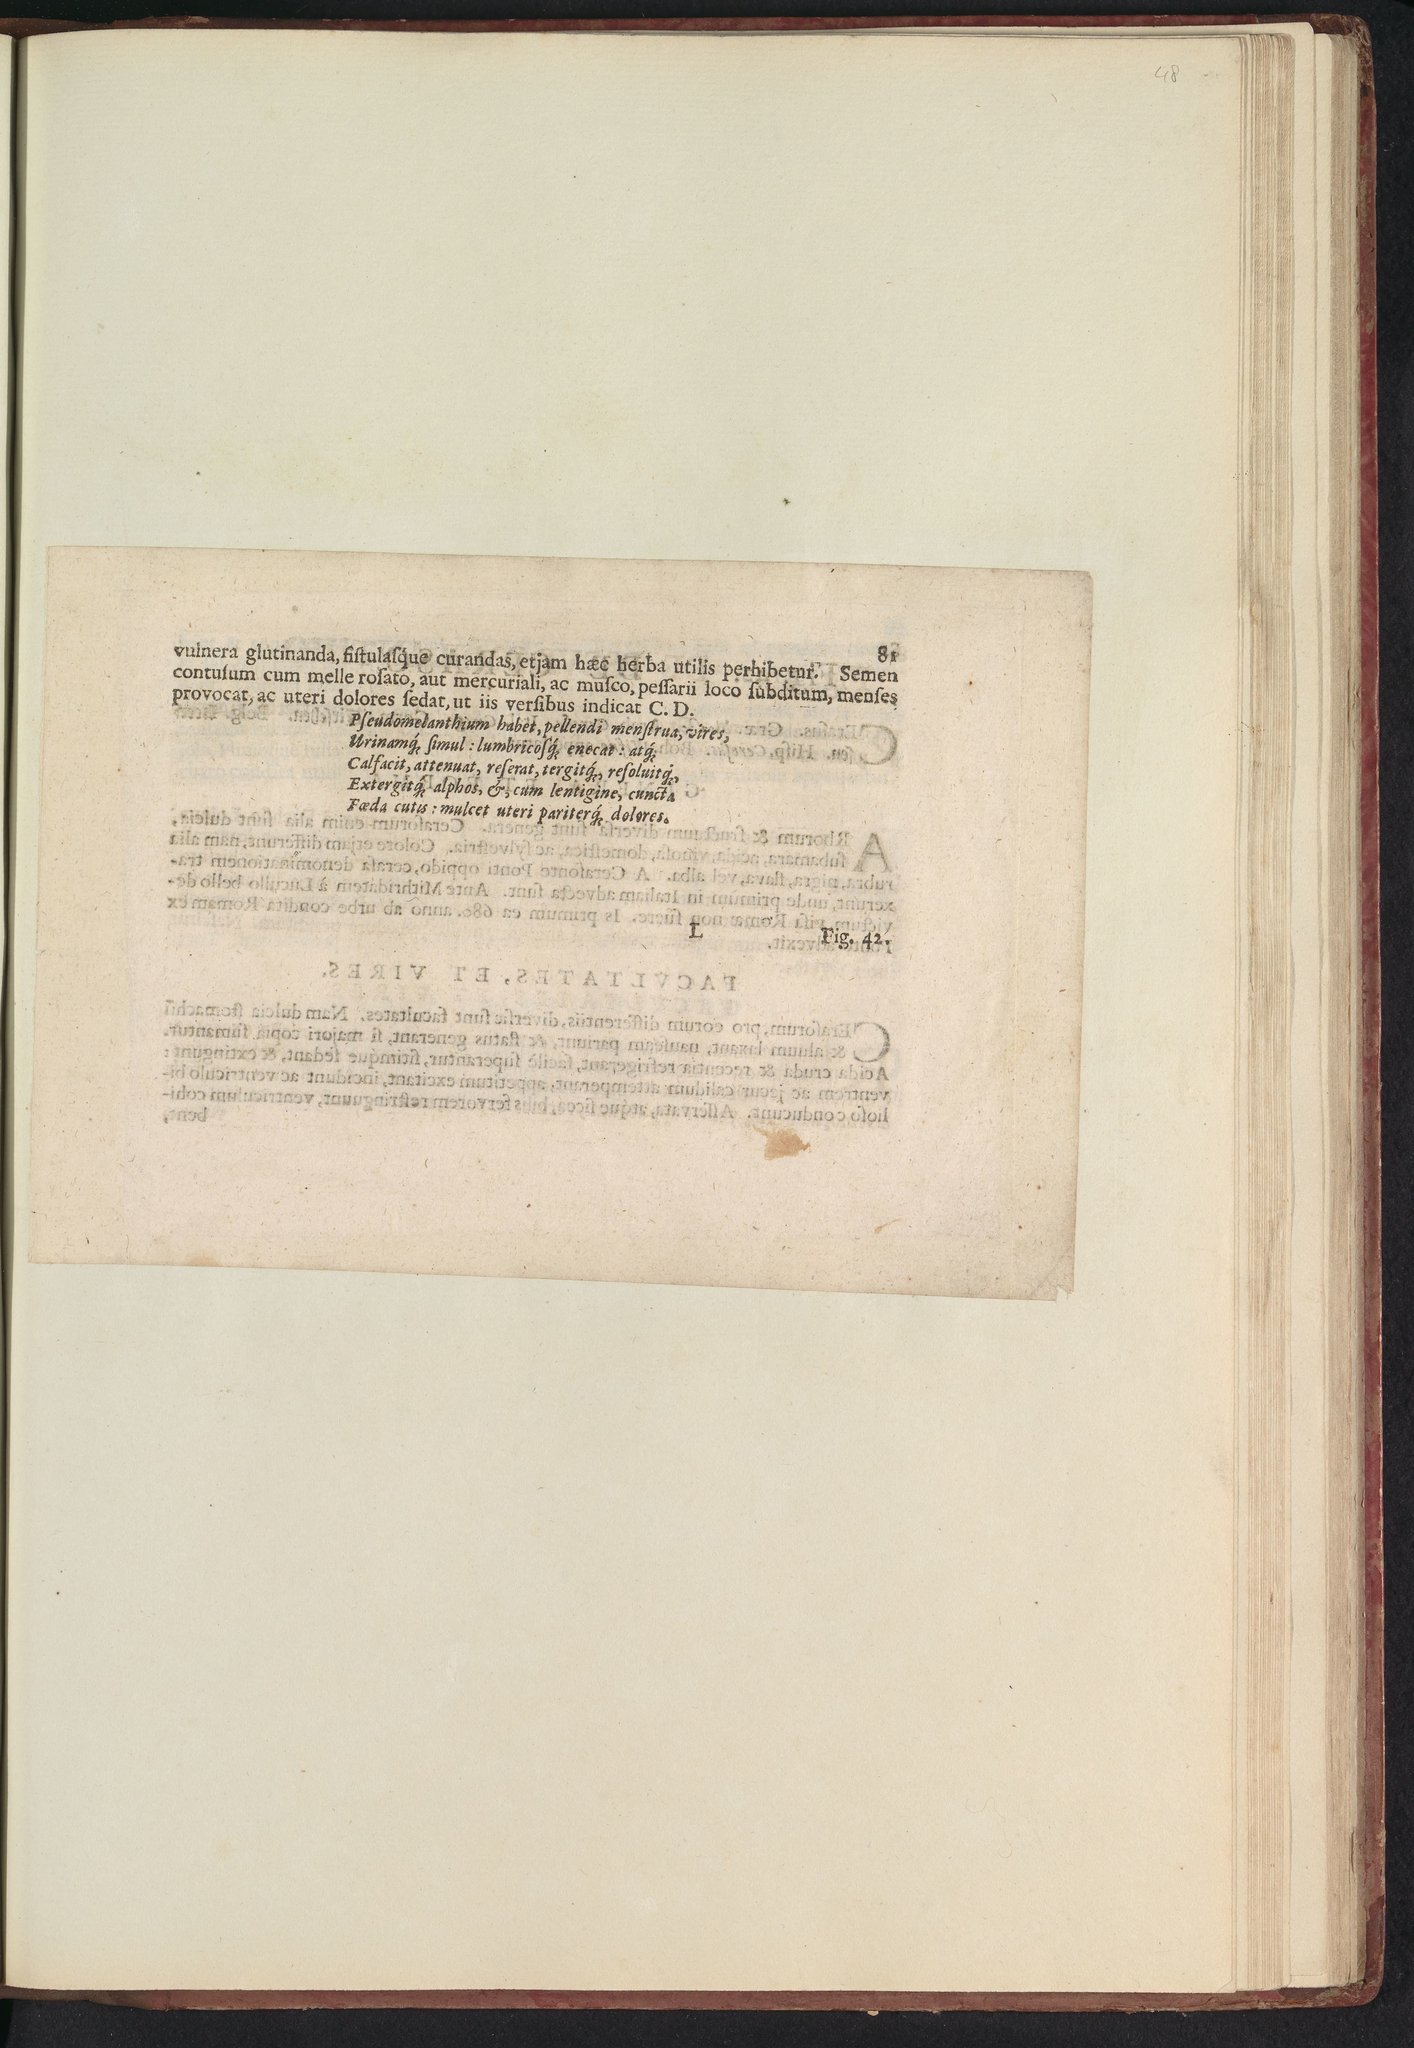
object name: text sheet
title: Fig. 41 'De Psevdomelanthio' in De Boodts herbarium van 1640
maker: anselmus boëtius de boodt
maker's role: draughtsman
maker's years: 1550-1632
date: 1640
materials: ink, paper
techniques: letterpress printing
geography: bruges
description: Beschrijving bij Fig. 41 op p. 81 in: Anselmi Boëtii de Boot I.C. Brugensis & Rodolphi II. Imp. Roman. medici a cubiculis Florum, Herbarum, ac fructuum selectiorum icones, & vires pleraeque hactenus ignotæ. Onderdeel van het album met bladen en platen uit De Boodts herbarium van 1640. Het twaalfde van twaalf albums met aquarellen van dieren, vogels en planten bekend rond 1600, gemaakt in opdracht van keizer Rudolf II.